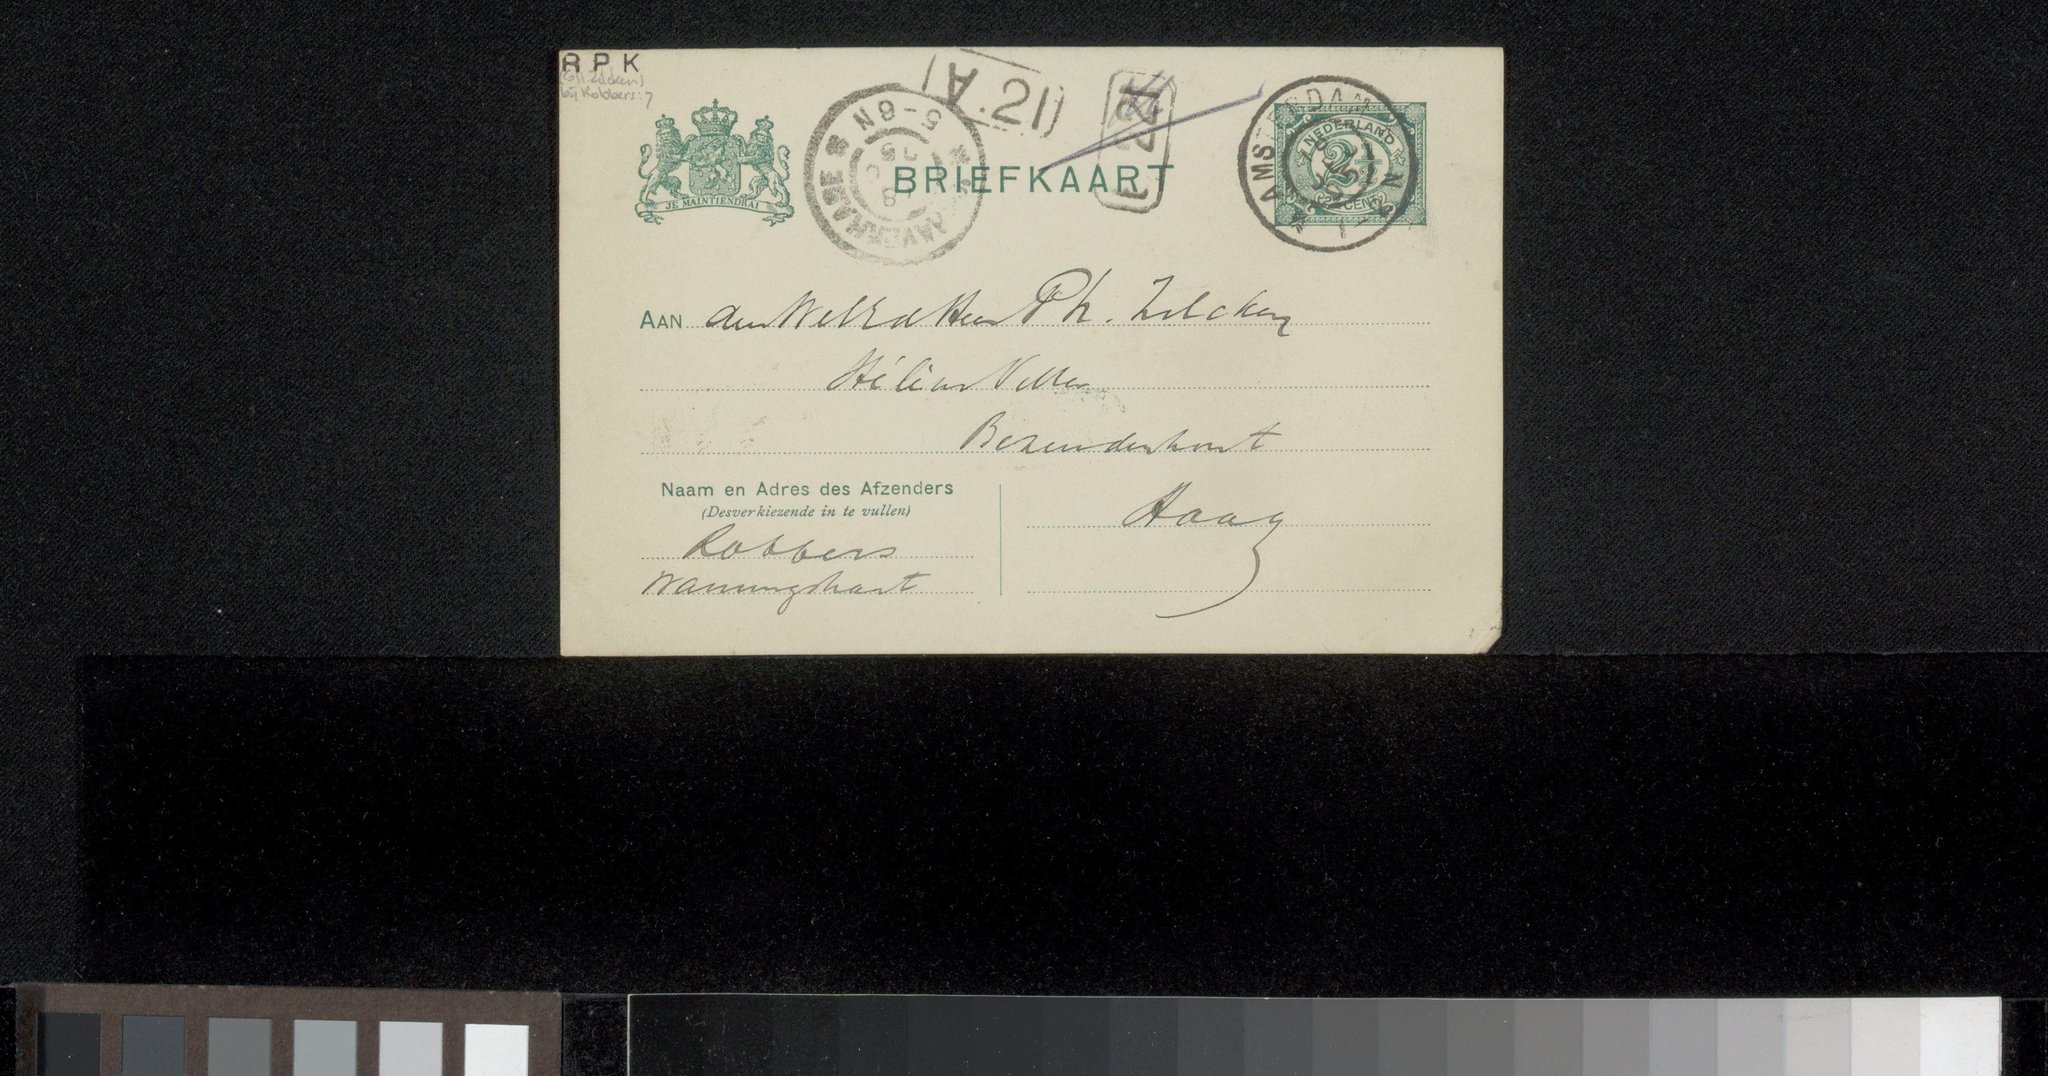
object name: postcard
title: Briefkaart aan Philip Zilcken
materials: cardboard, ink, pencil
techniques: pen, writing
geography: amsterdam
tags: delft, print maker, draughtsman, antoon derkzen van angeren, new york (city), samuel putnam avery, the hague, painter, philip zilcken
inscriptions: collector's mark: ‘RPK’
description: Briefkaart bevat aantekening van Philip Zilcken.